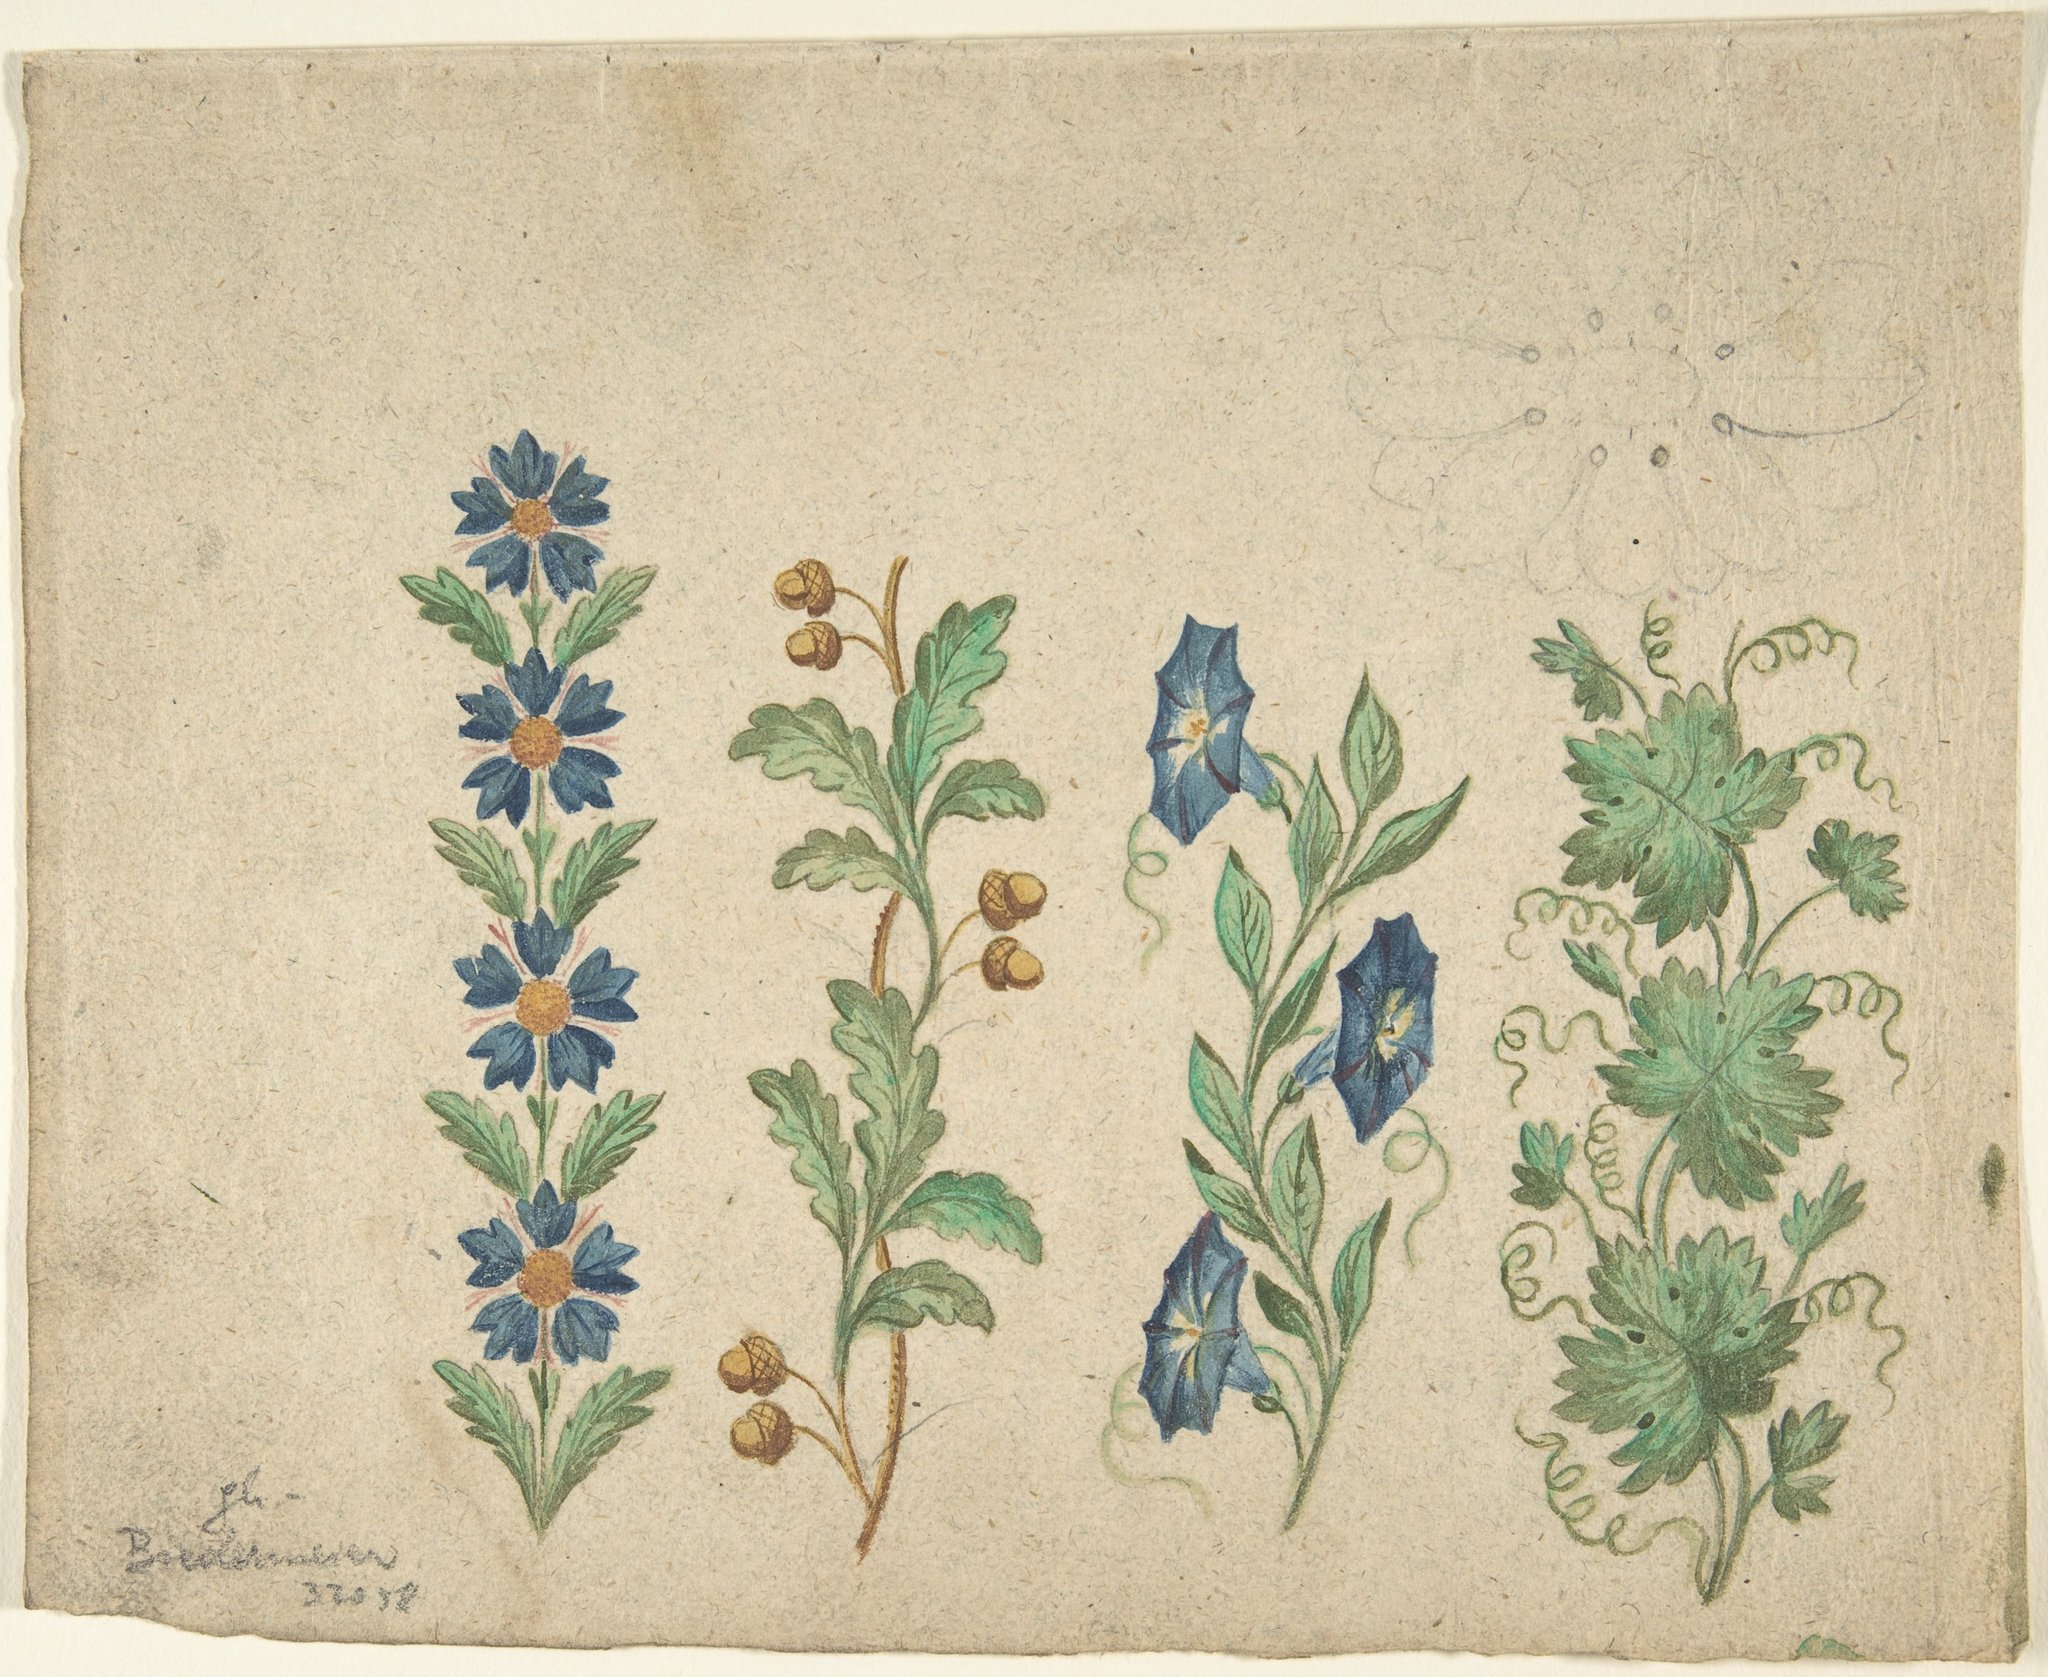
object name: drawing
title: Designs for Embroidery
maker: anonymous, german, 19th century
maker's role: artist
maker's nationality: german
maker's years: 1800-1899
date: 1801-1900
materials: chalk, watercolor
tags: flowers,leaves